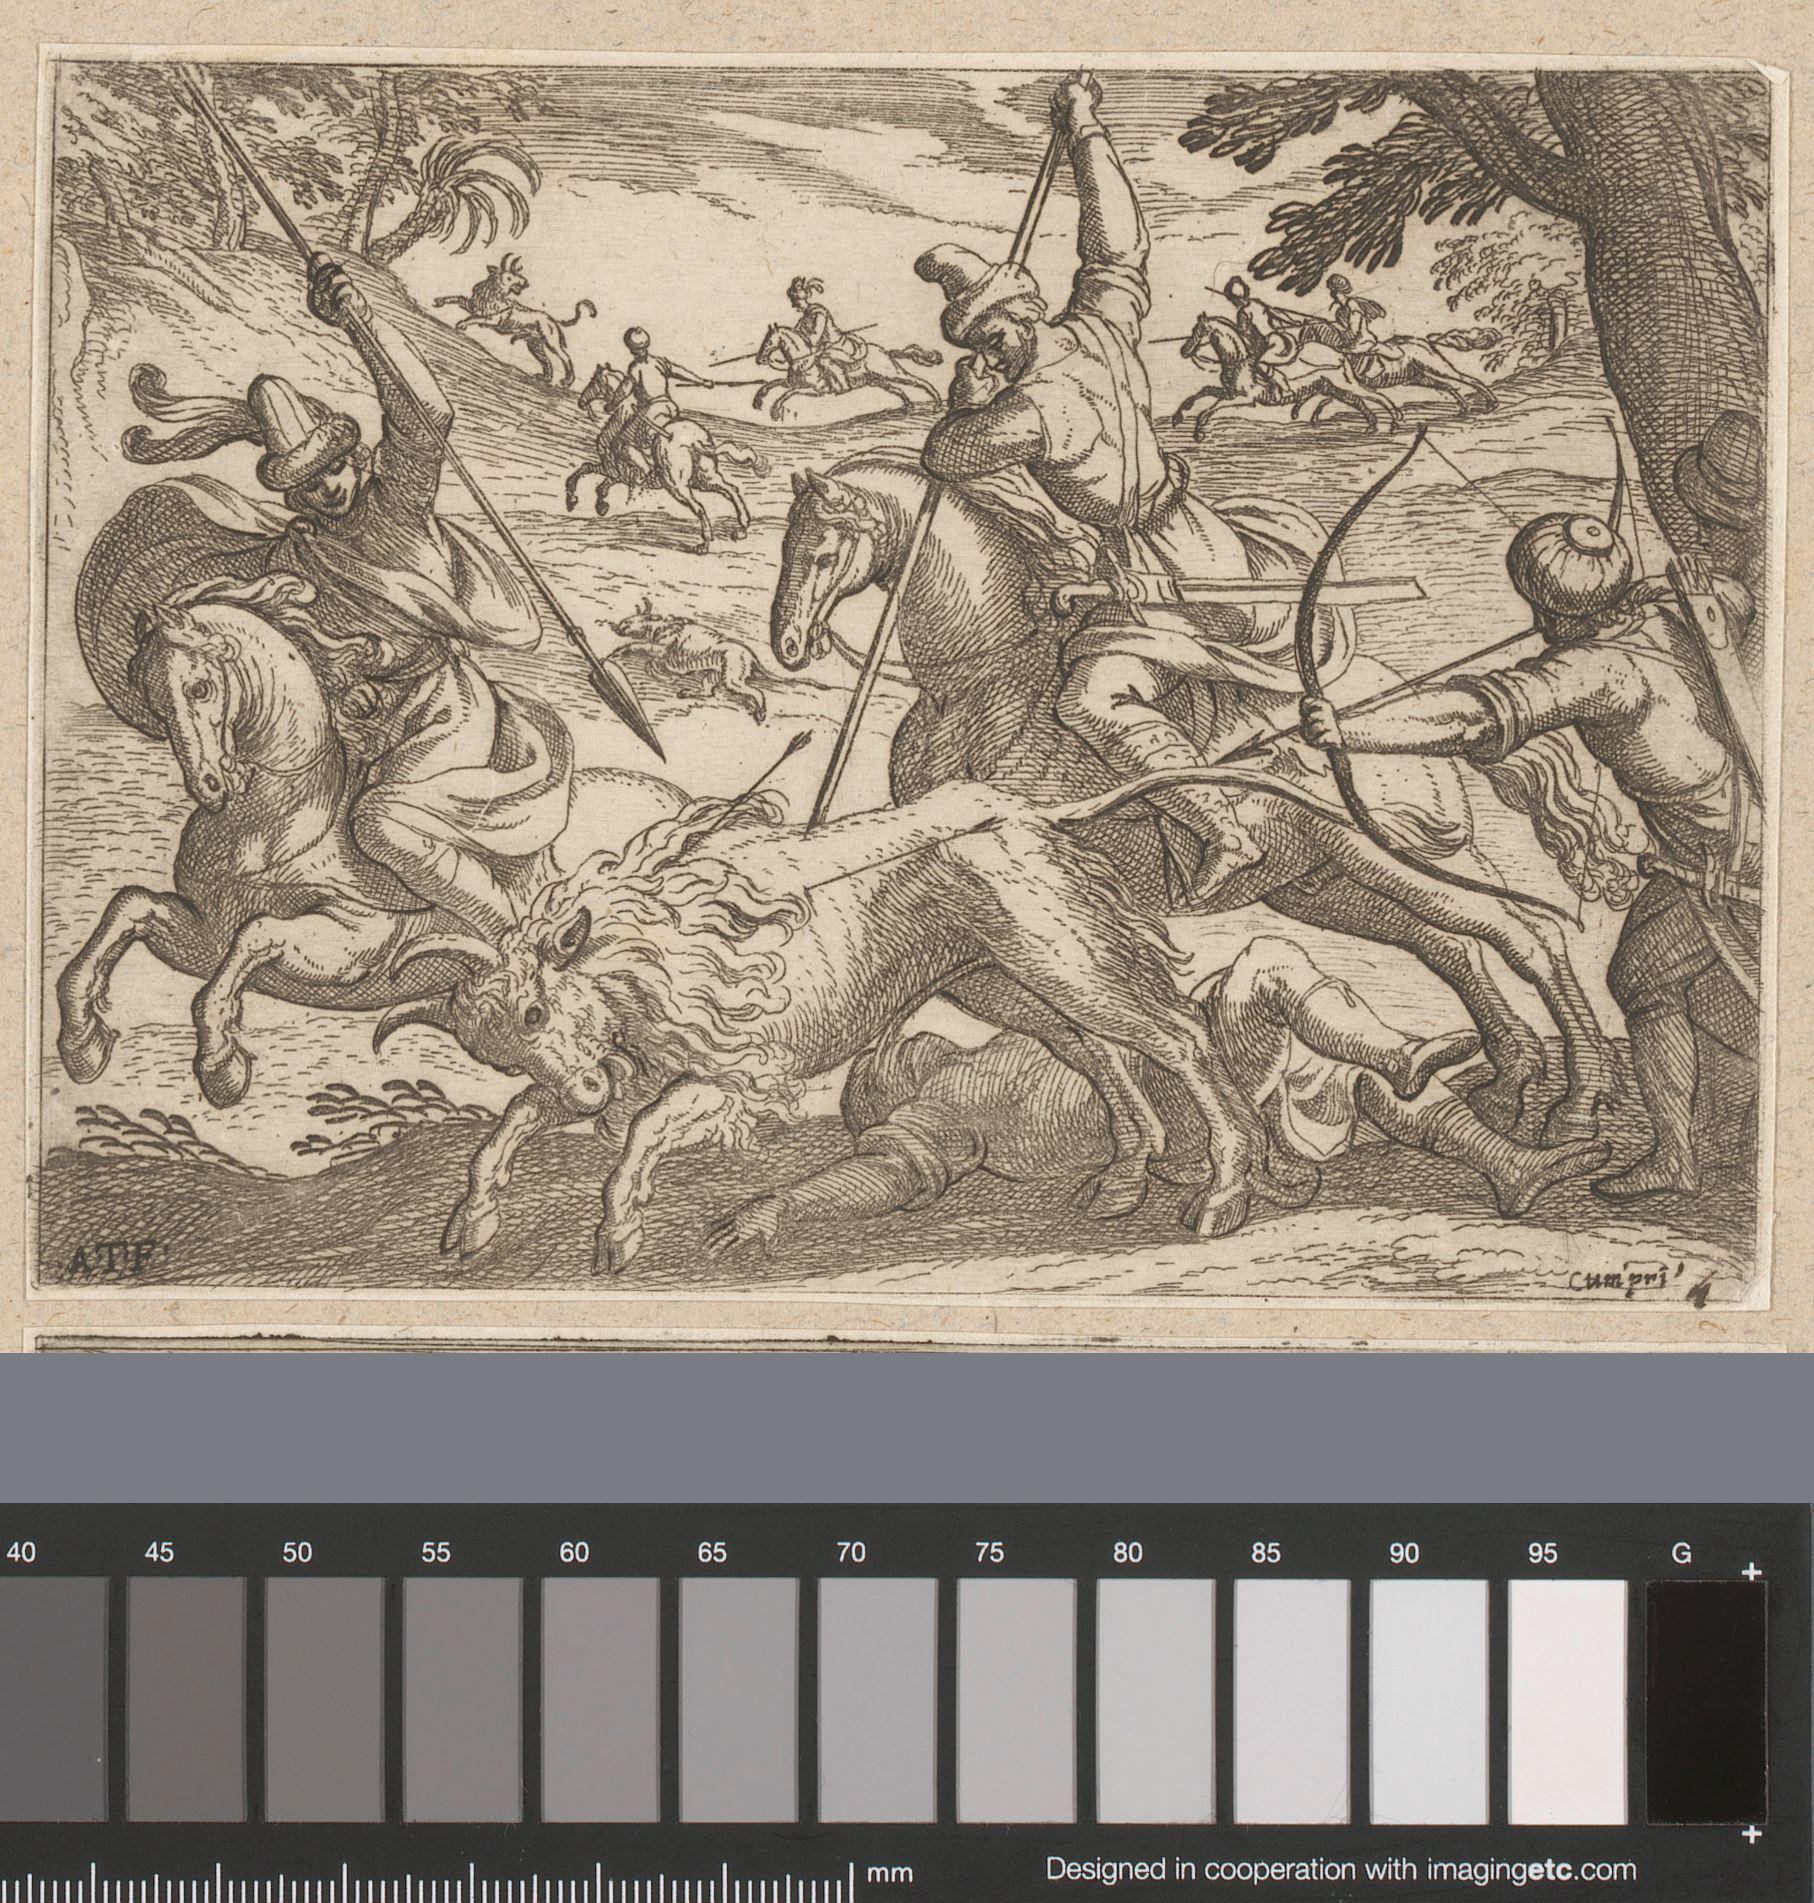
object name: print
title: Jacht op wilde stieren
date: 1598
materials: paper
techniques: etching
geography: vatican city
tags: bull, hunter, hunters hunting (n.b.: in 1988-1990 this notation denoted the concept of 43c11421 'hunters resting during the hunt'), hunt ~ mammals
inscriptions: number: ‘4’, collector's mark: ‘Hinloopen’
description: Landschap met mannen met speren te paard en mannen met pijl-en-boog jagend op wilde stieren.